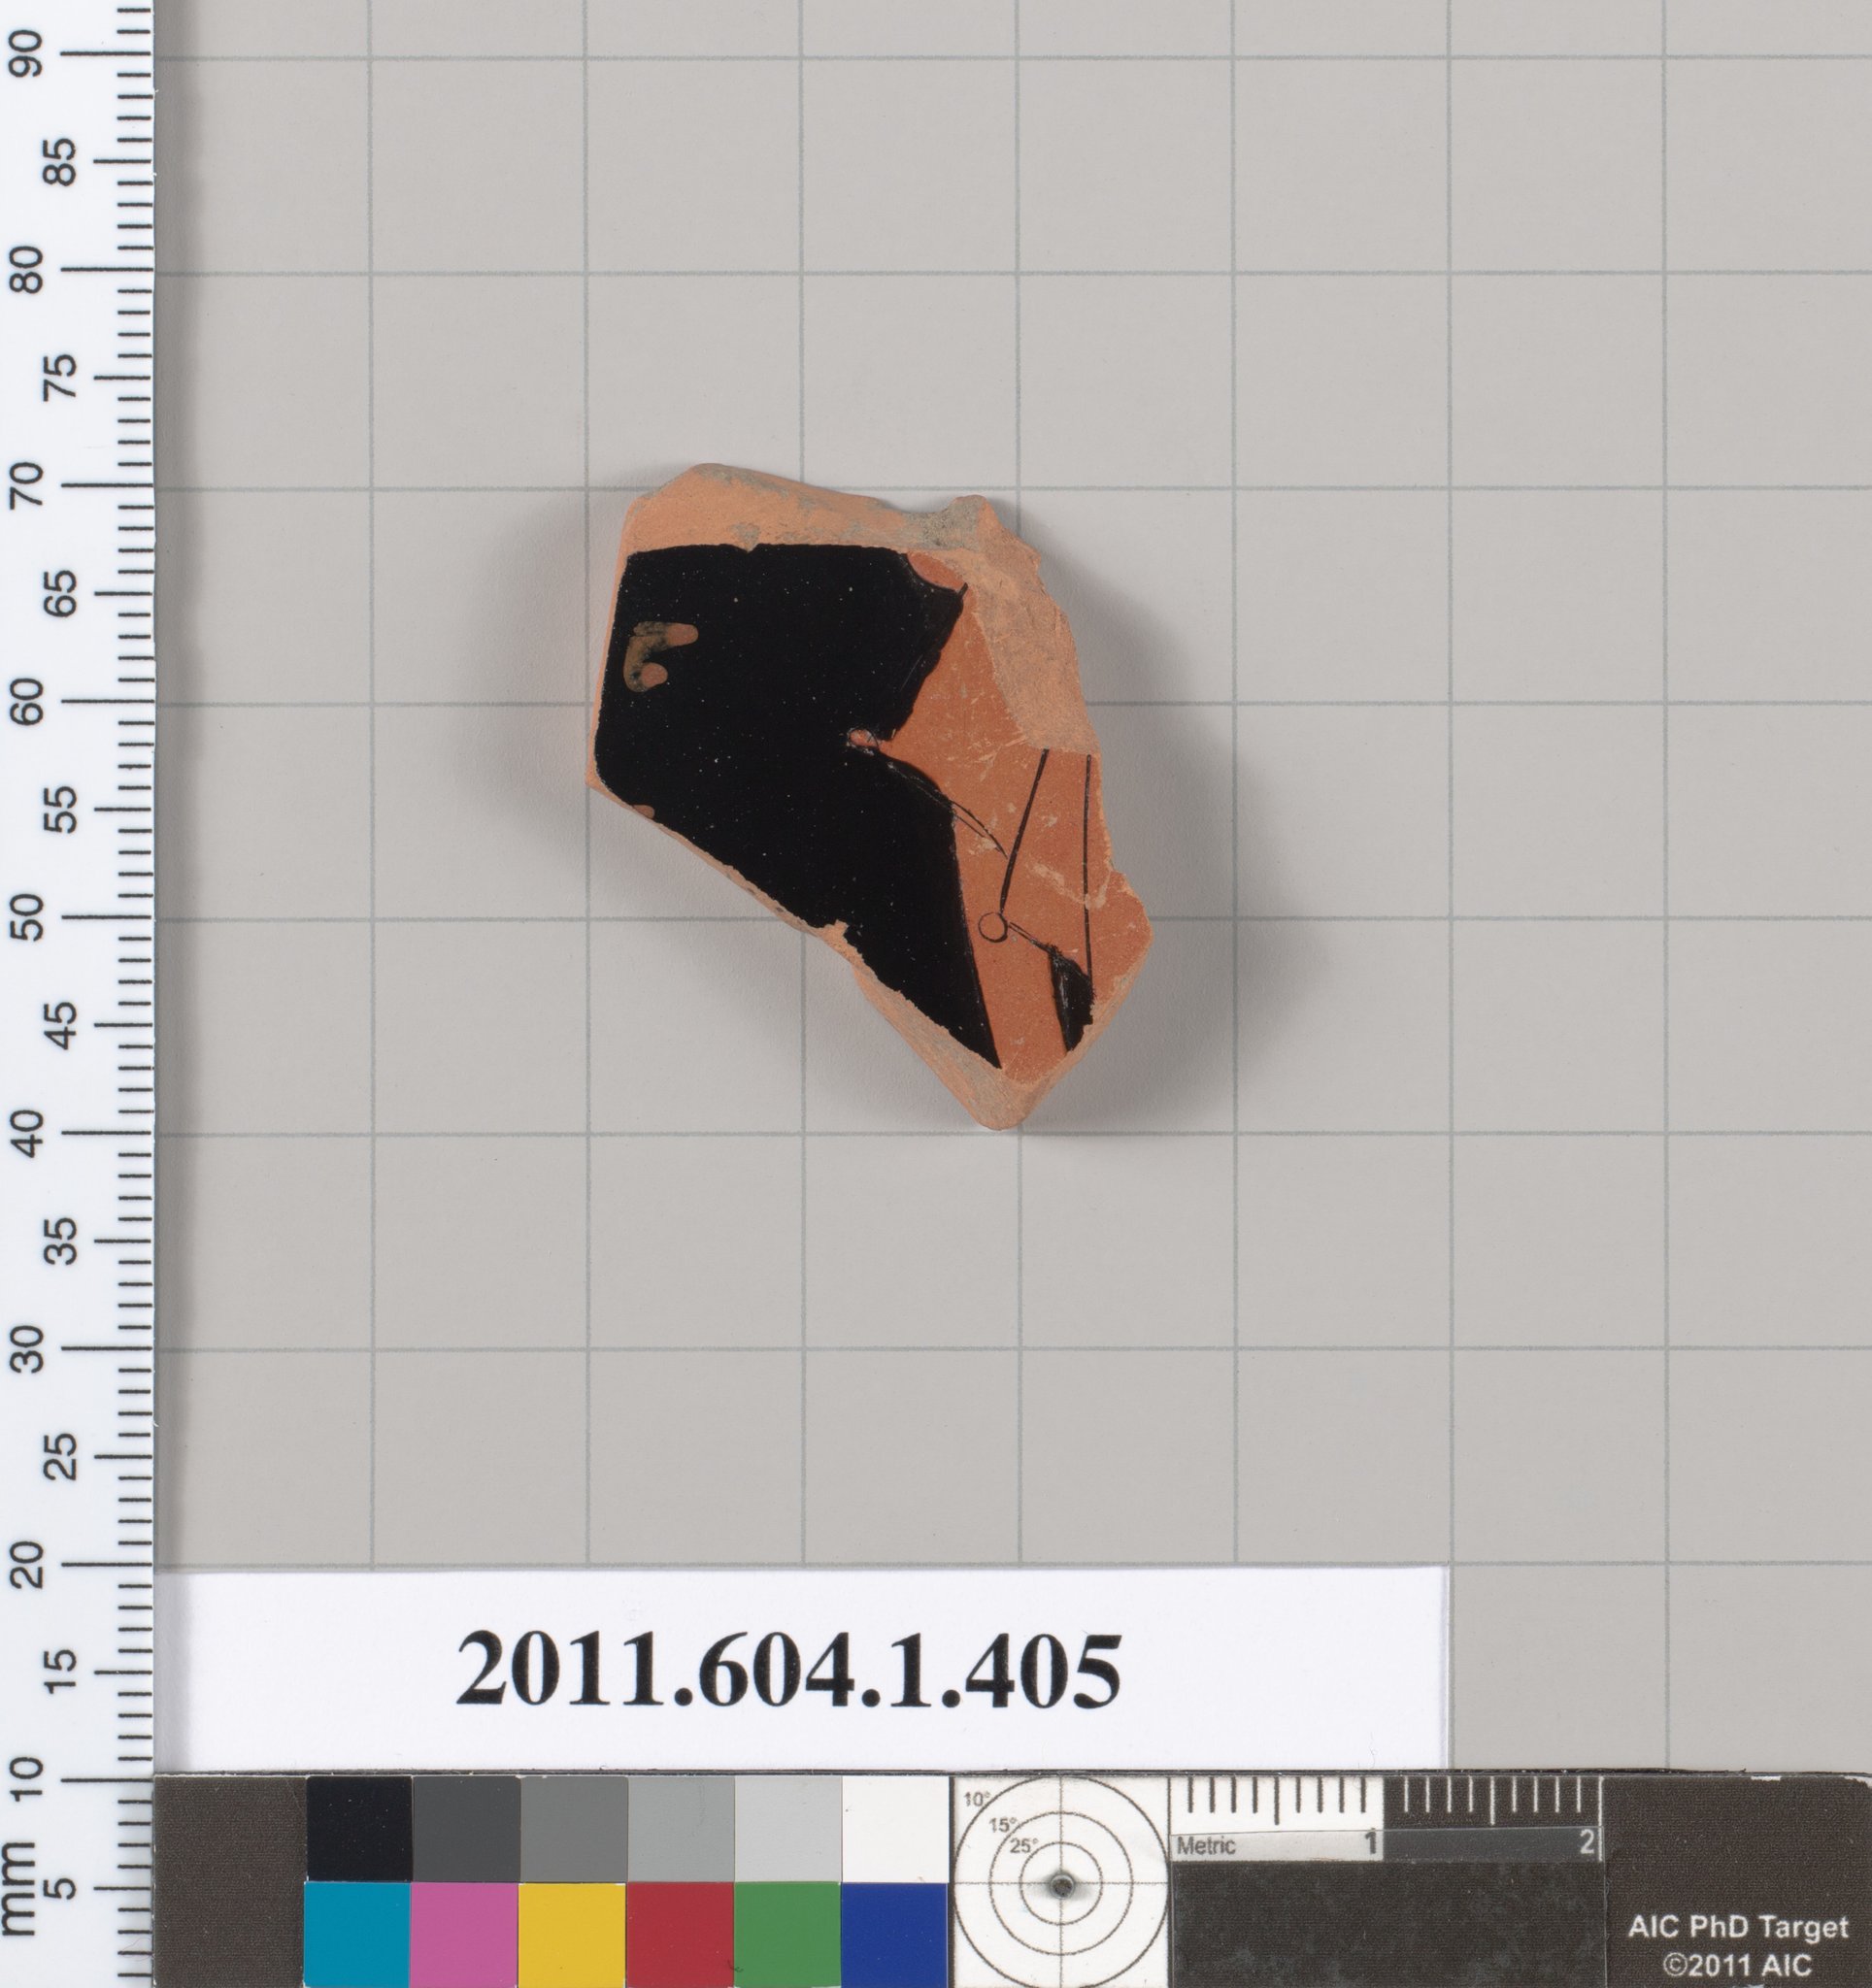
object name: kylix fragment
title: Terracotta fragment of a kylix (drinking cup)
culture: greek, attic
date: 475-451 BCE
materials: terracotta